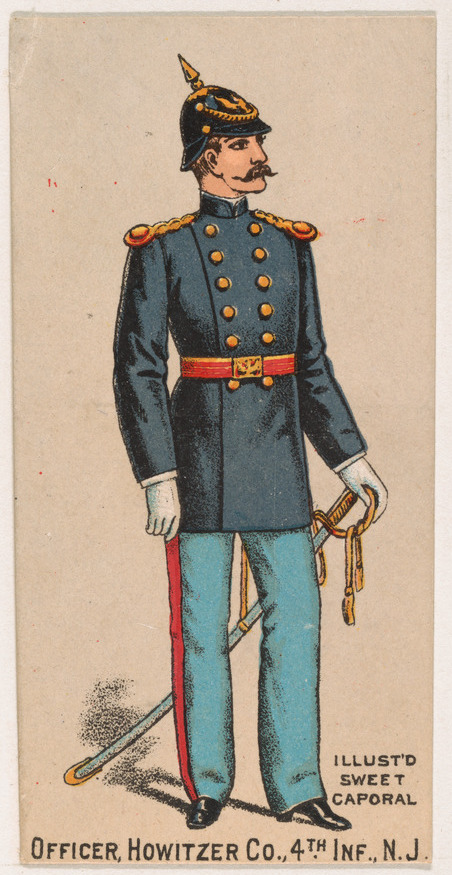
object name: print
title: Officer, Howitzer Company, 4th Infantry, New Jersey, from the Military Series (N224) issued by Kinney Tobacco Company to promote Sweet Caporal Cigarettes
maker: kinney brothers tobacco company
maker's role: publisher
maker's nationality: american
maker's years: 1869-2011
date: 1888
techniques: color lithograph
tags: military,swords,men